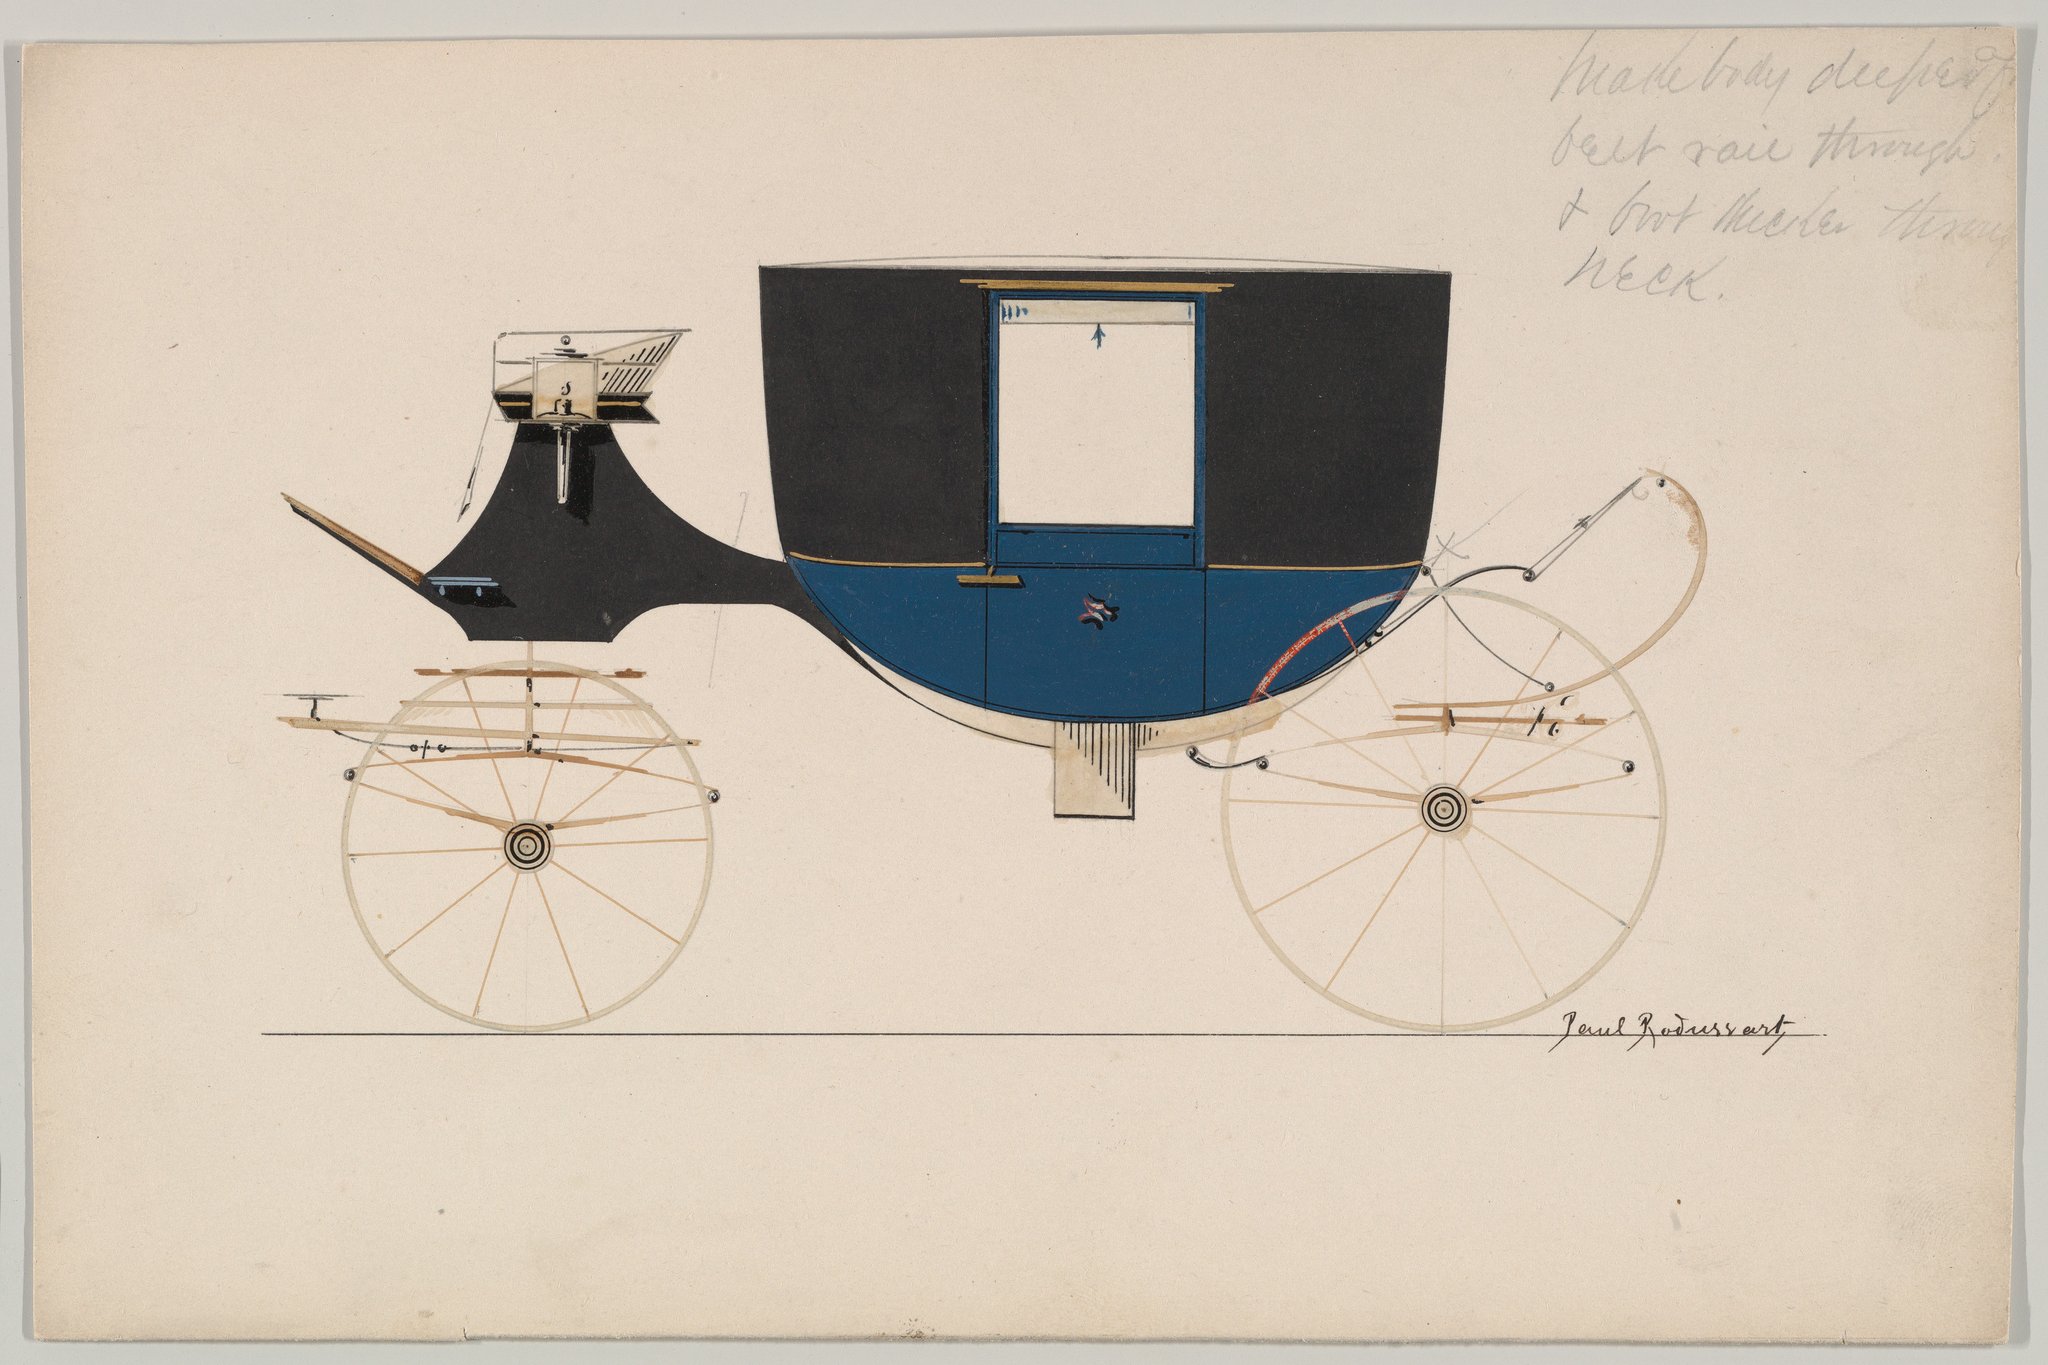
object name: drawing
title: Coach (unnumbered)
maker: brewster & co.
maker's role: manufacturer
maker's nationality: american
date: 1870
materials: gouache, graphite, ink, watercolor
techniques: pen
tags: carriages